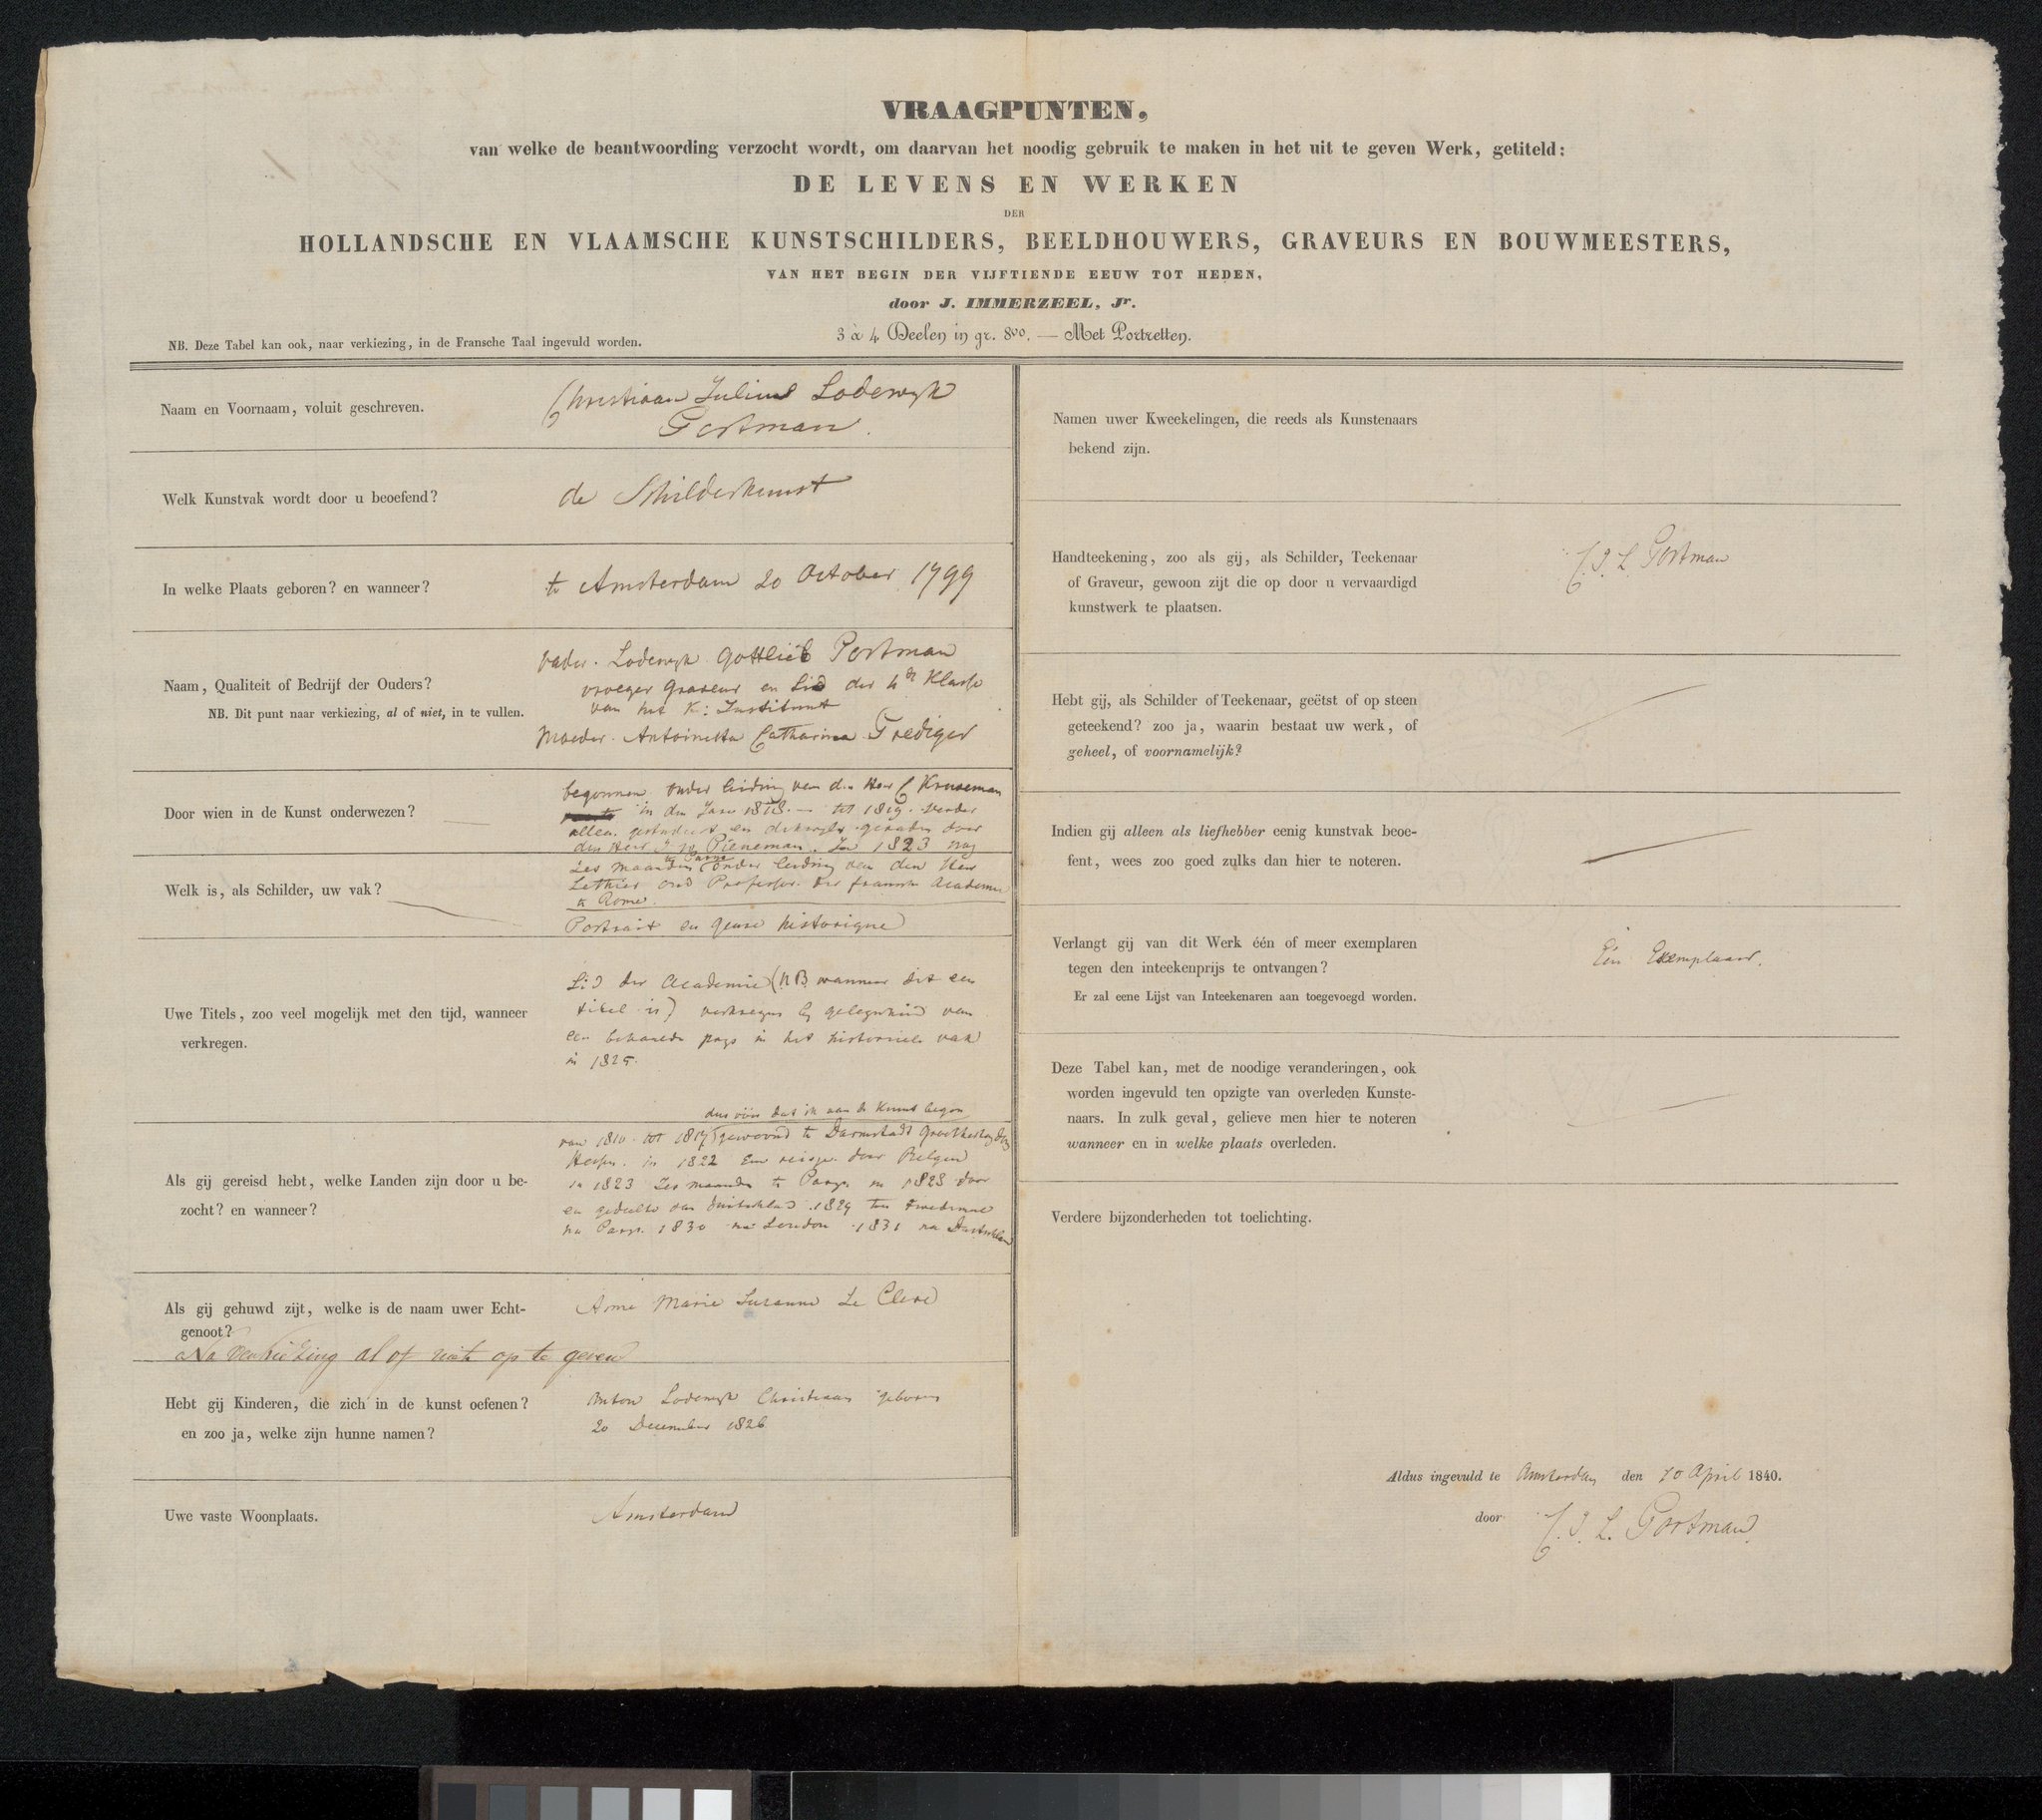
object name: manuscript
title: Enquêteformulier ingevuld door Christiaan Julius Lodewijk Portman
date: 1840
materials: ink, paper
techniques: pen, printing, writing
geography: amsterdam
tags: painter, draughtsman, christiaan julius lodewijk portman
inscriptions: watermark, inscription: ‘Vraagpunten,/ van welke de beantwoording verzocht wordt, om daarvan het noodig gebruik te maken in het uit te geven Werk, getiteld: De levens en werken/ der Hollandsche en Vlaamsche kunstschilders, beeldhouwers,/ graveurs en bouwmeesters, van het begin der vijftiende eeuw tot heden/ door J. Immerzeel, Jr.’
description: Opgenomen in: Immerzeel, J. Jr., De levens en werken der Hollandsche en Vlaamsche kunstschilders, beeldhouwers, graveurs en bouwmeesters, van het begin der vijftiende eeuw tot heden, Amsterdam: J.C. van Kesteren, 1842-1843.